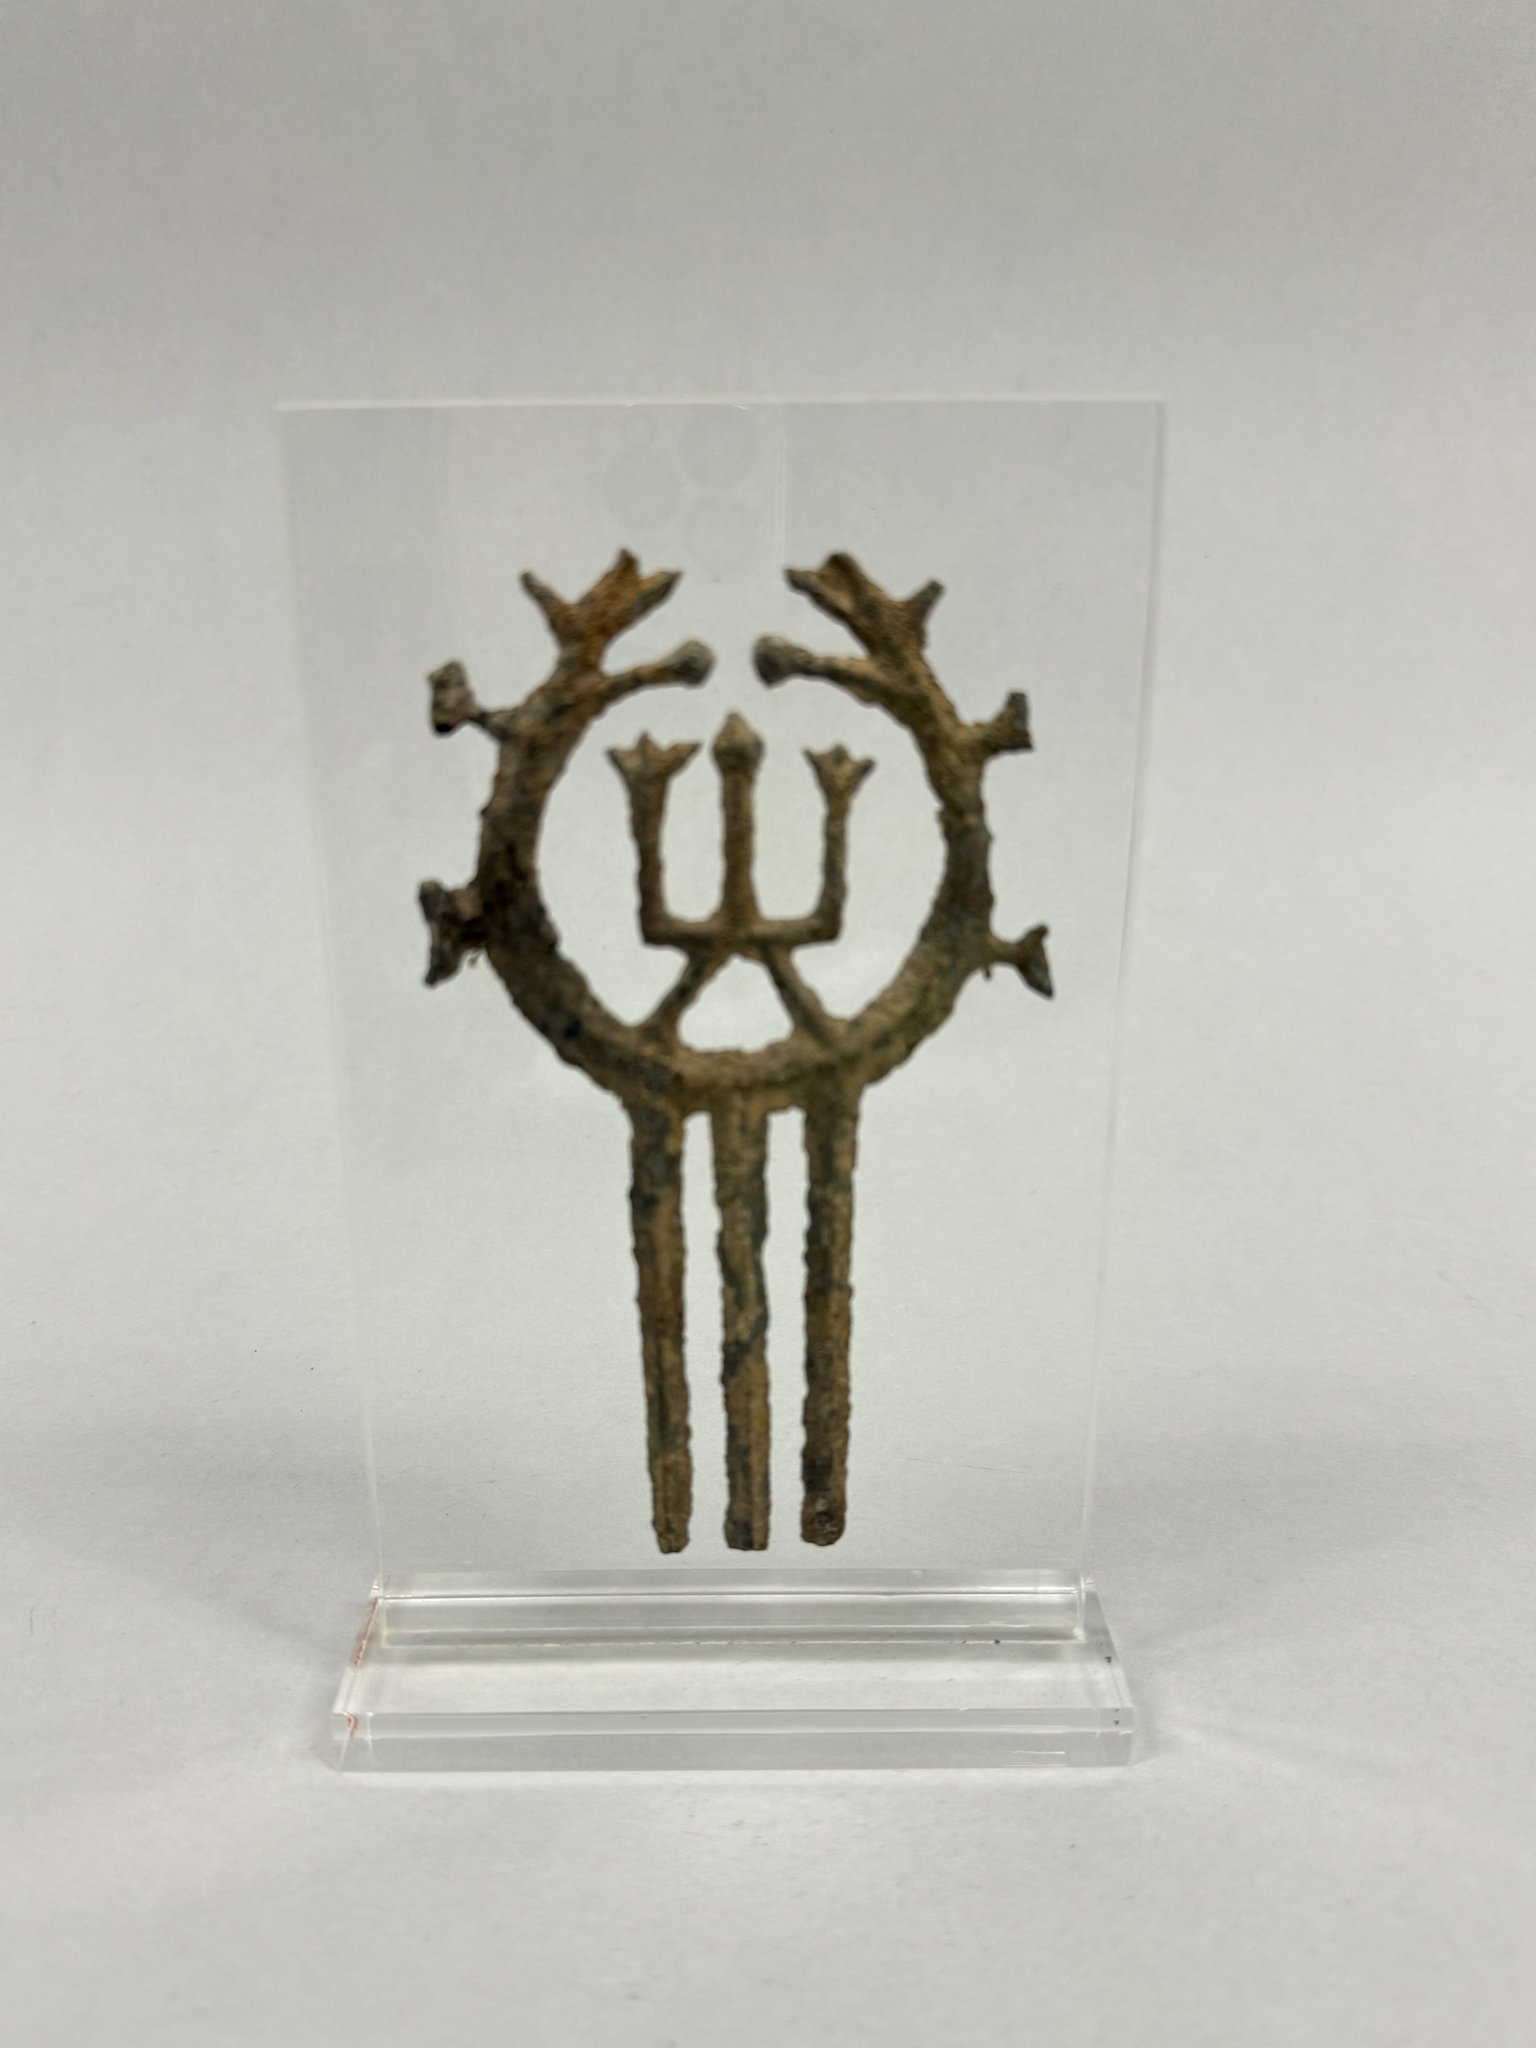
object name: comb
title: Comb (?)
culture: vietnamese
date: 500 BCE-300 CE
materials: bronze